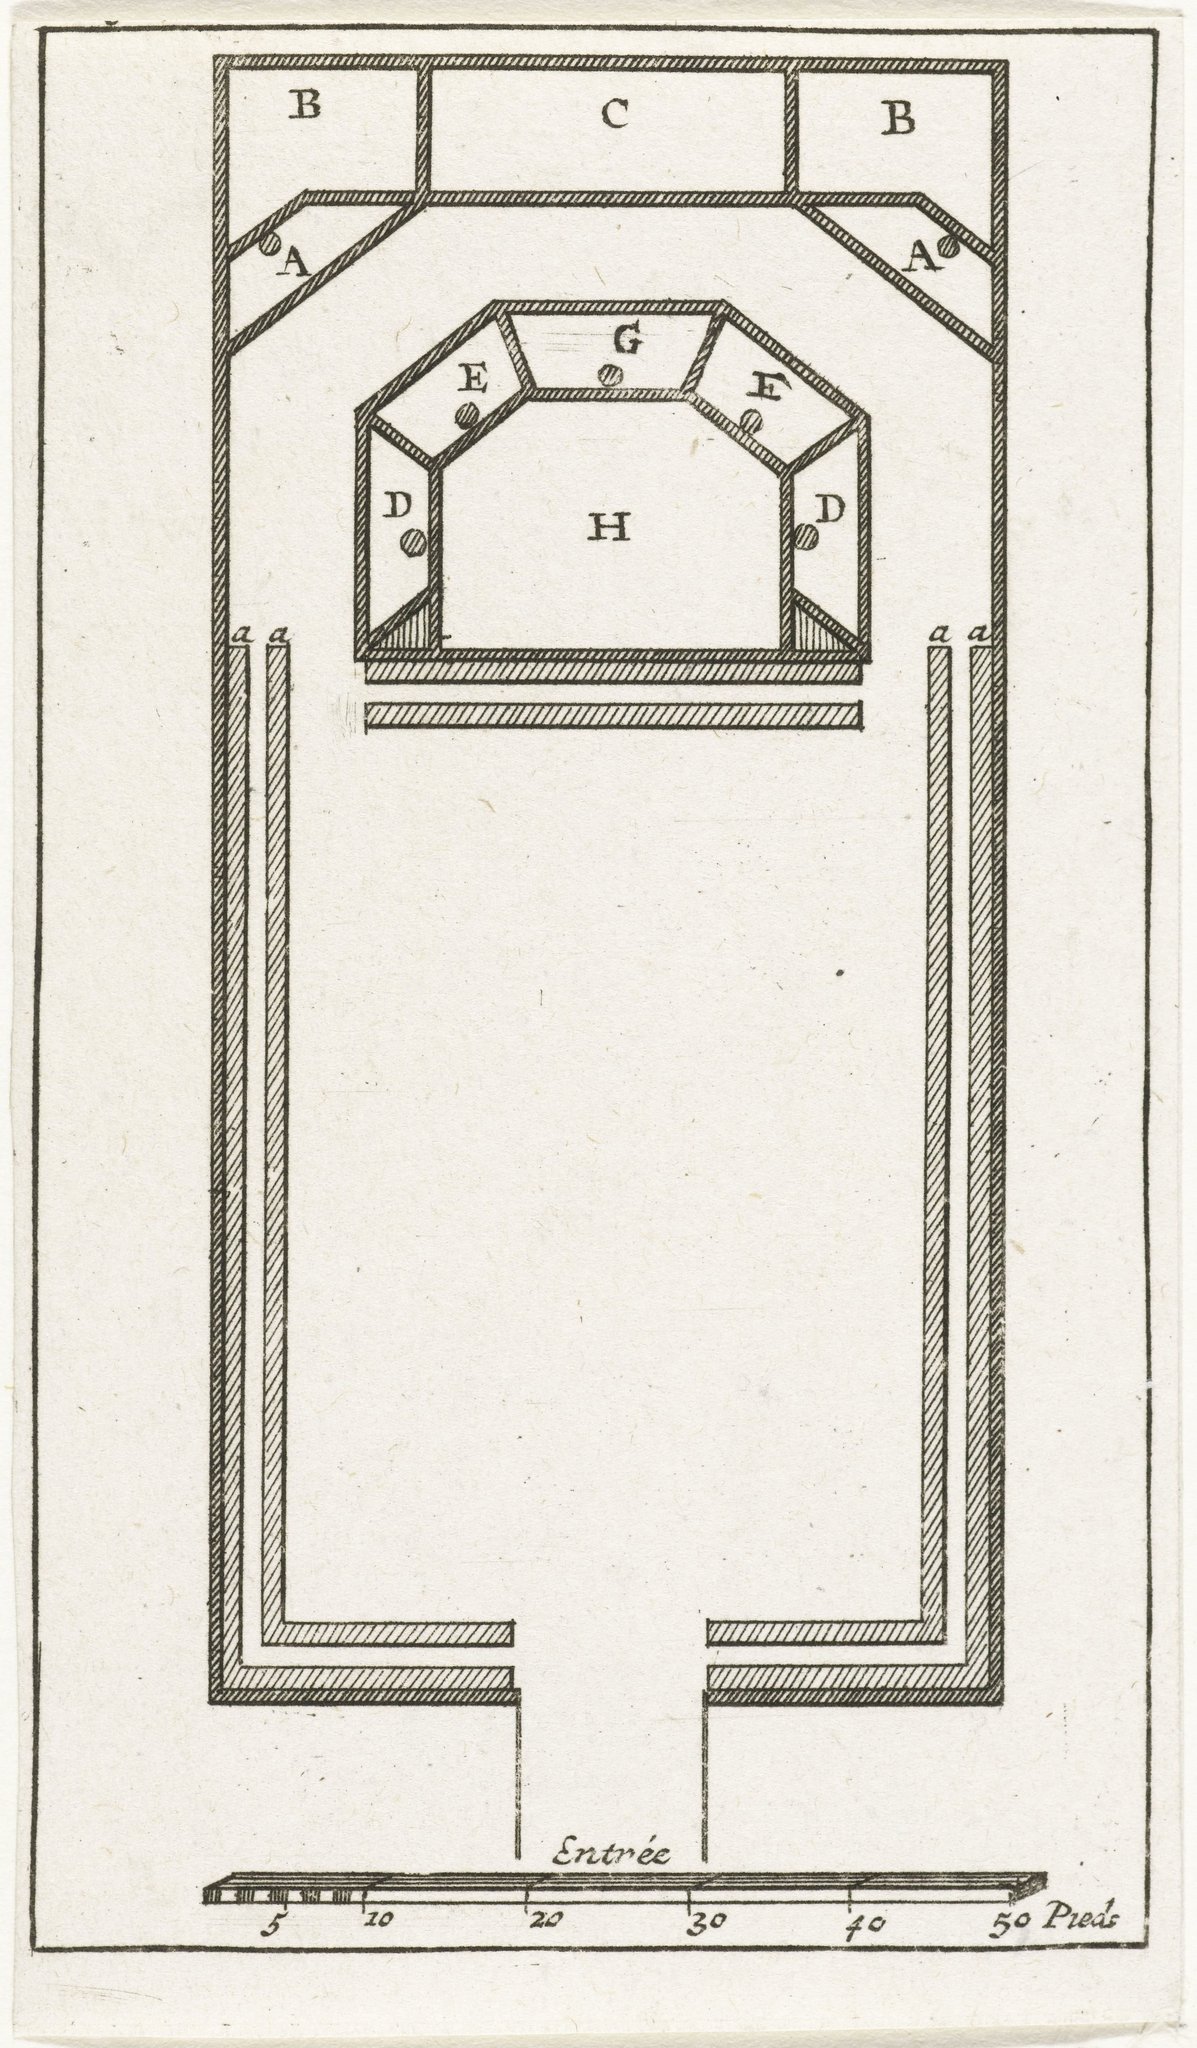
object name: print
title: Plattegrond, 1714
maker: Anonymous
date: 1714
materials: paper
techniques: etching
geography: northern netherlands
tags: public festivities at birth of royal persons, plan ~ architecture, utrecht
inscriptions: collector's mark: Lugt 2228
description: Plattegrond van een zaal, wellicht gebruikt voor de toneelvoorstellingen en bal, 1714. Onderdeel van een groep van twaalf illustraties van de feestelijkheden georganiseerd in Utrecht in 1714 door de Portugese graaf Joao Gomes da Silva conde de Tarouca ter ere van de geboorte van twee Portugese prinsjes van koning Johan V.